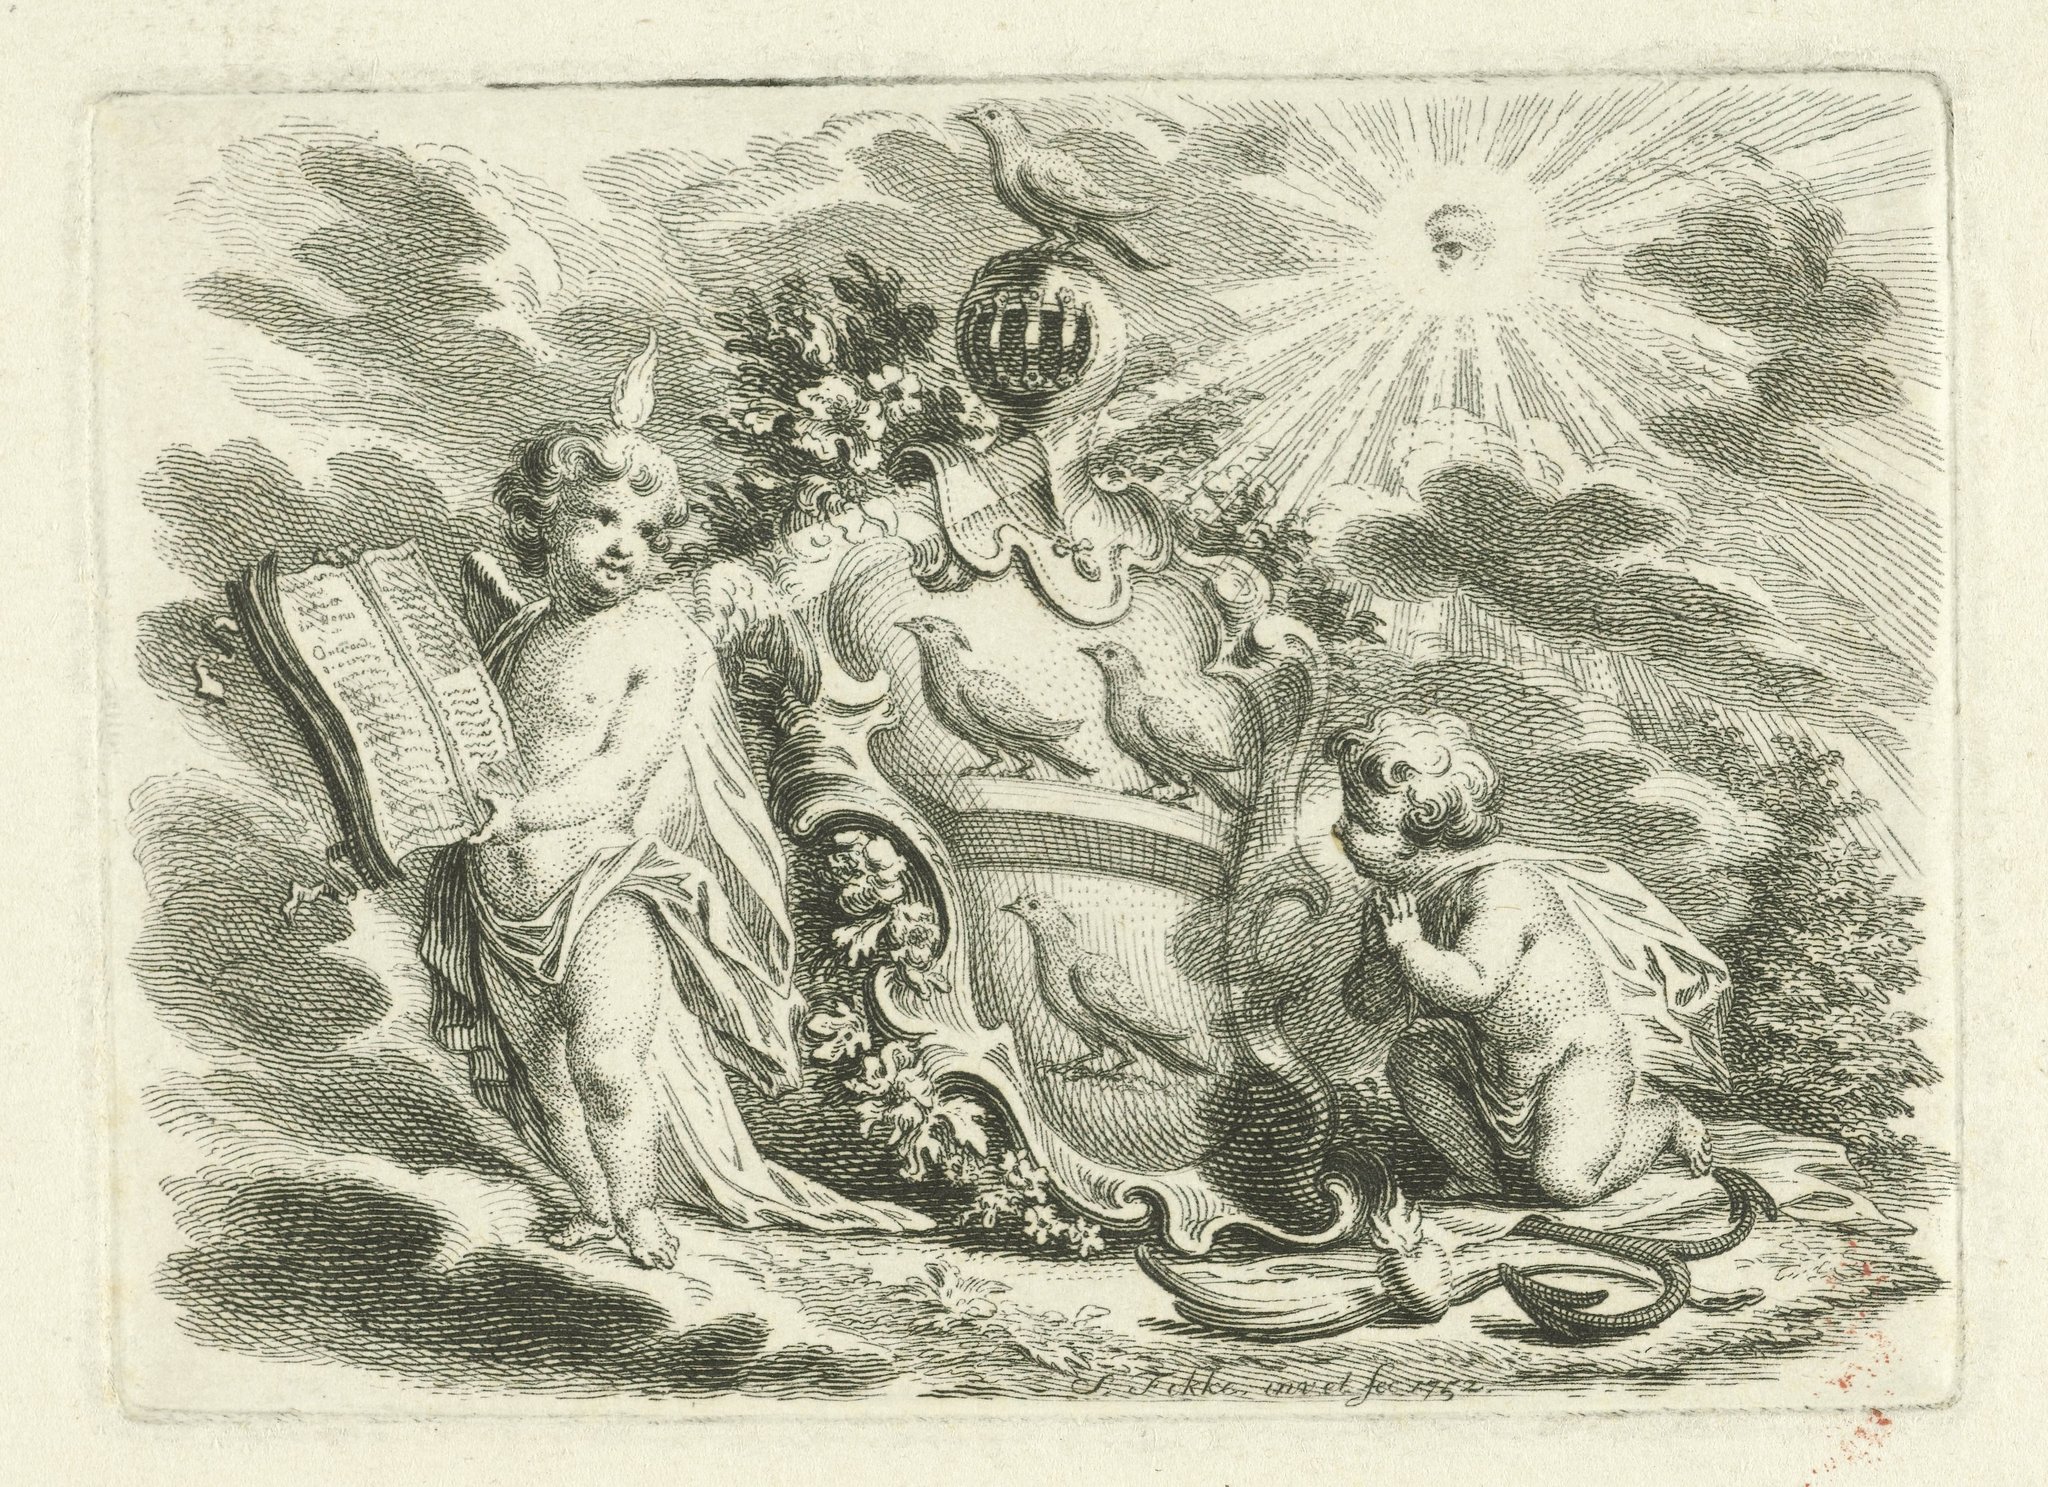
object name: print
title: Twee putti bij gehelmd wapenschild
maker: simon fokke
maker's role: draughtsman, print maker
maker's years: 1712-1784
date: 1752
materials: paper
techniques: etching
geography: amsterdam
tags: the all-seeing eye, triangle with eye ~ symbol of god the father, cupids: 'amores', 'amoretti', 'putti', armorial bearing, heraldry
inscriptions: collector's mark: Lugt 240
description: Twee putti bij een gehelmd wapenschild met de beeltenis van drie vogels. Rechts knielt een putto met ineengevouwen handen voor het schild. Links houdt een tweede putto een boek open waarop een bundel licht, afkomstig van het Alziend oog, valt.